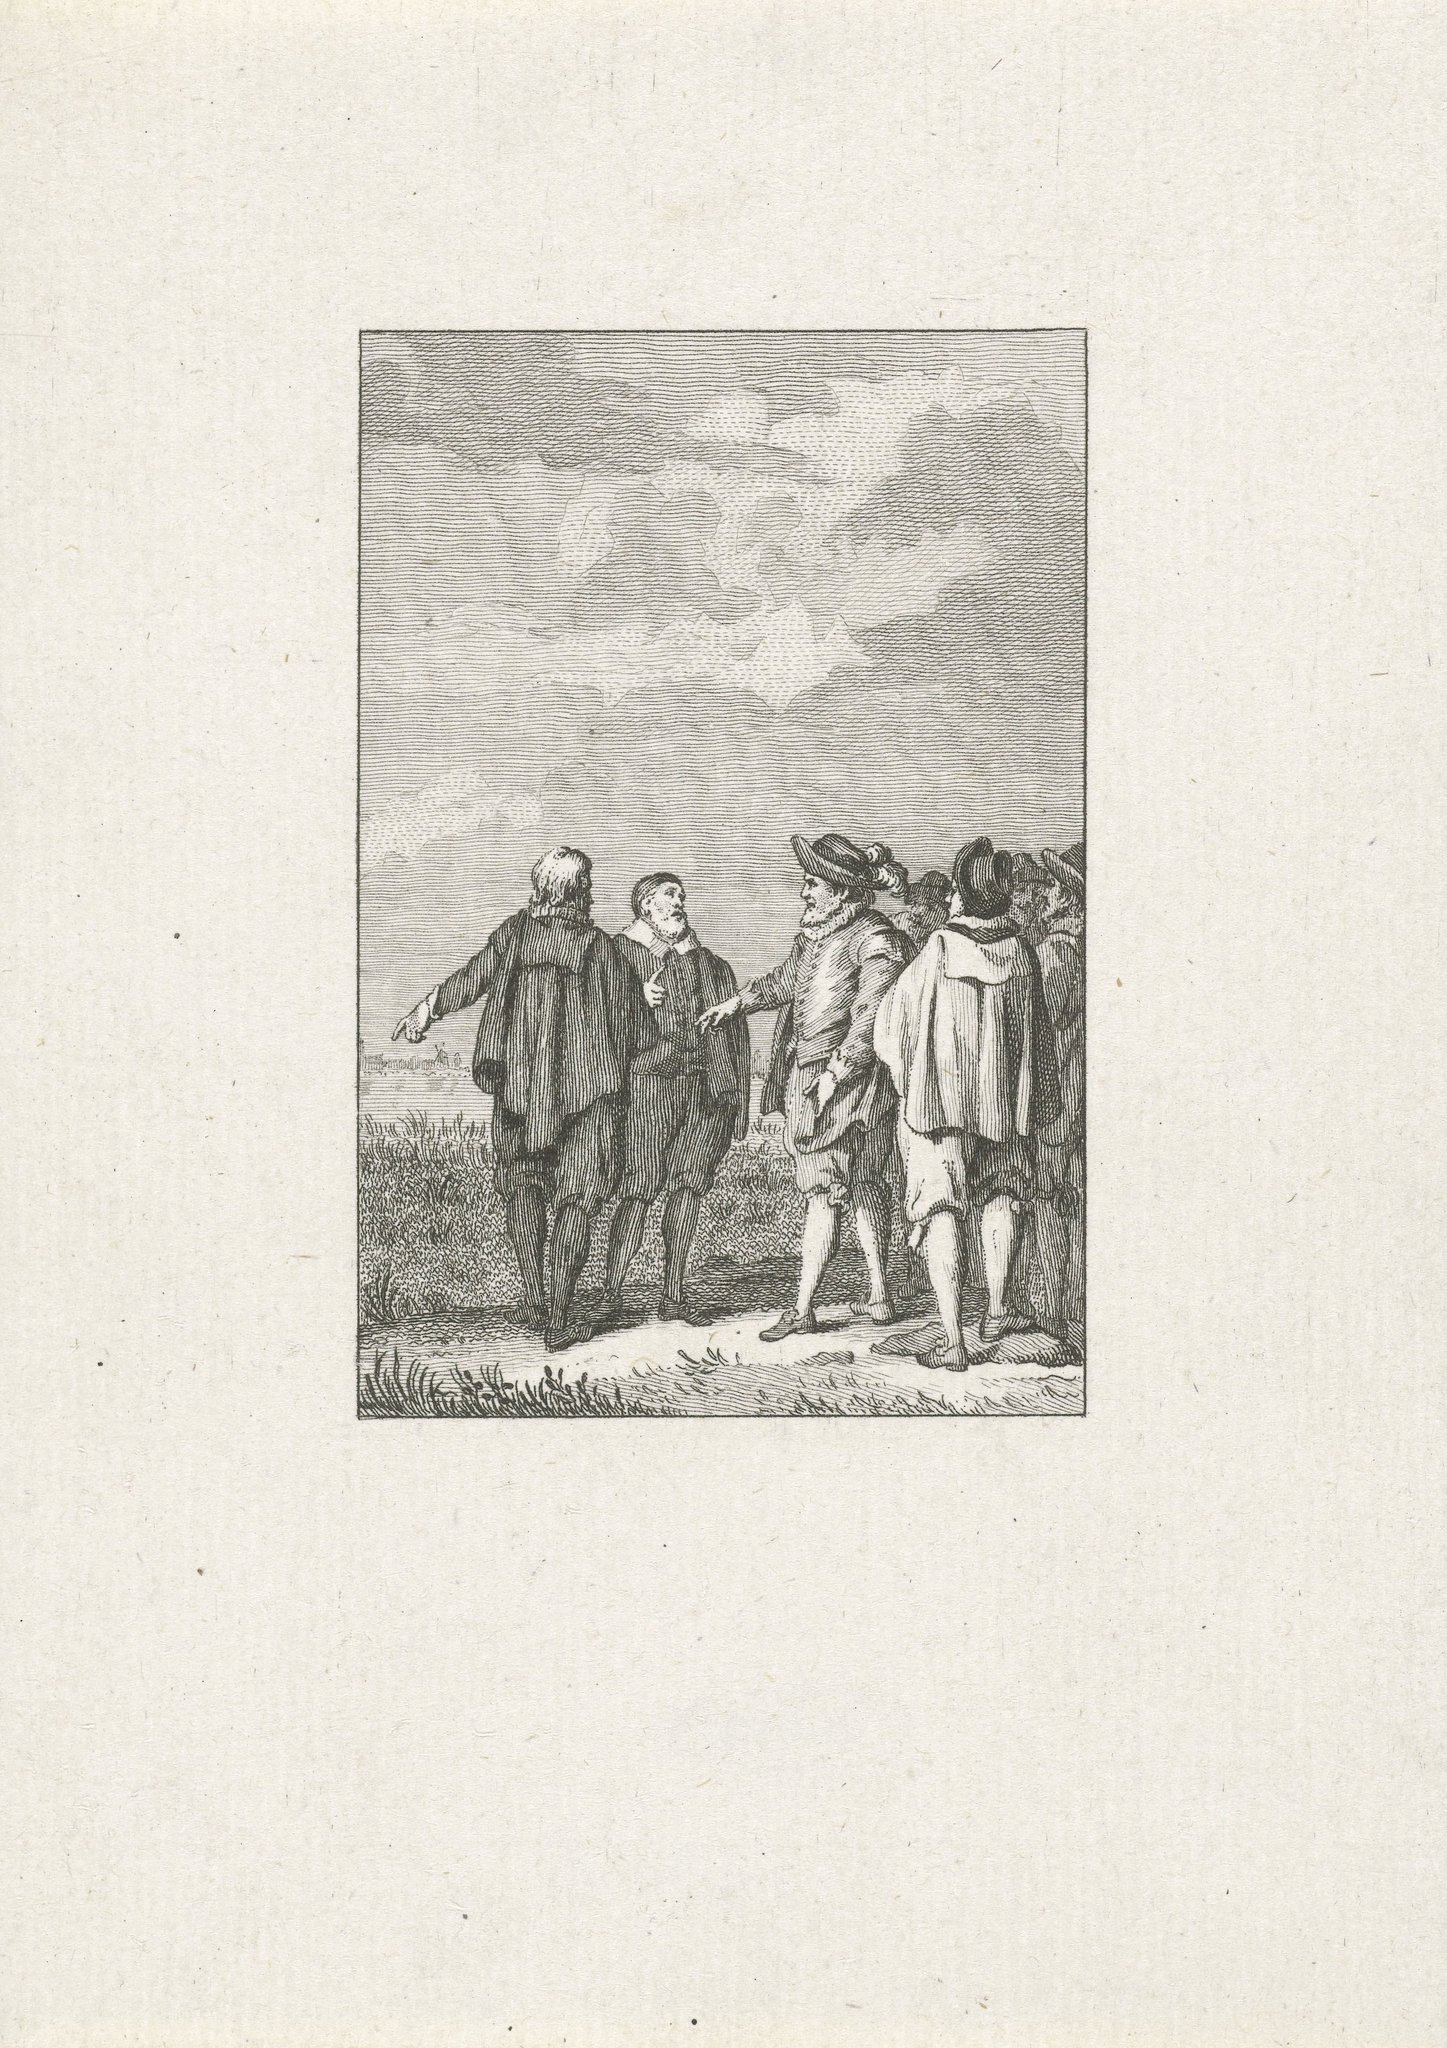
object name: print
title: Overleg tussen zes voorname Amsterdammers, 1566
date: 1780-1795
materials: paper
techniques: etching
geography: netherlands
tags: debate, discussion (~ meeting), amsterdam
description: Illustratie voor: J. Fokke, Geschiedenissen der Vereenigde Nederlanden voor de vaderlandsche jeugd, Johannes Allart, Amsterdam 1783-1795, 25 delen, dl. IV, pl. III. Staat vóór de letter.